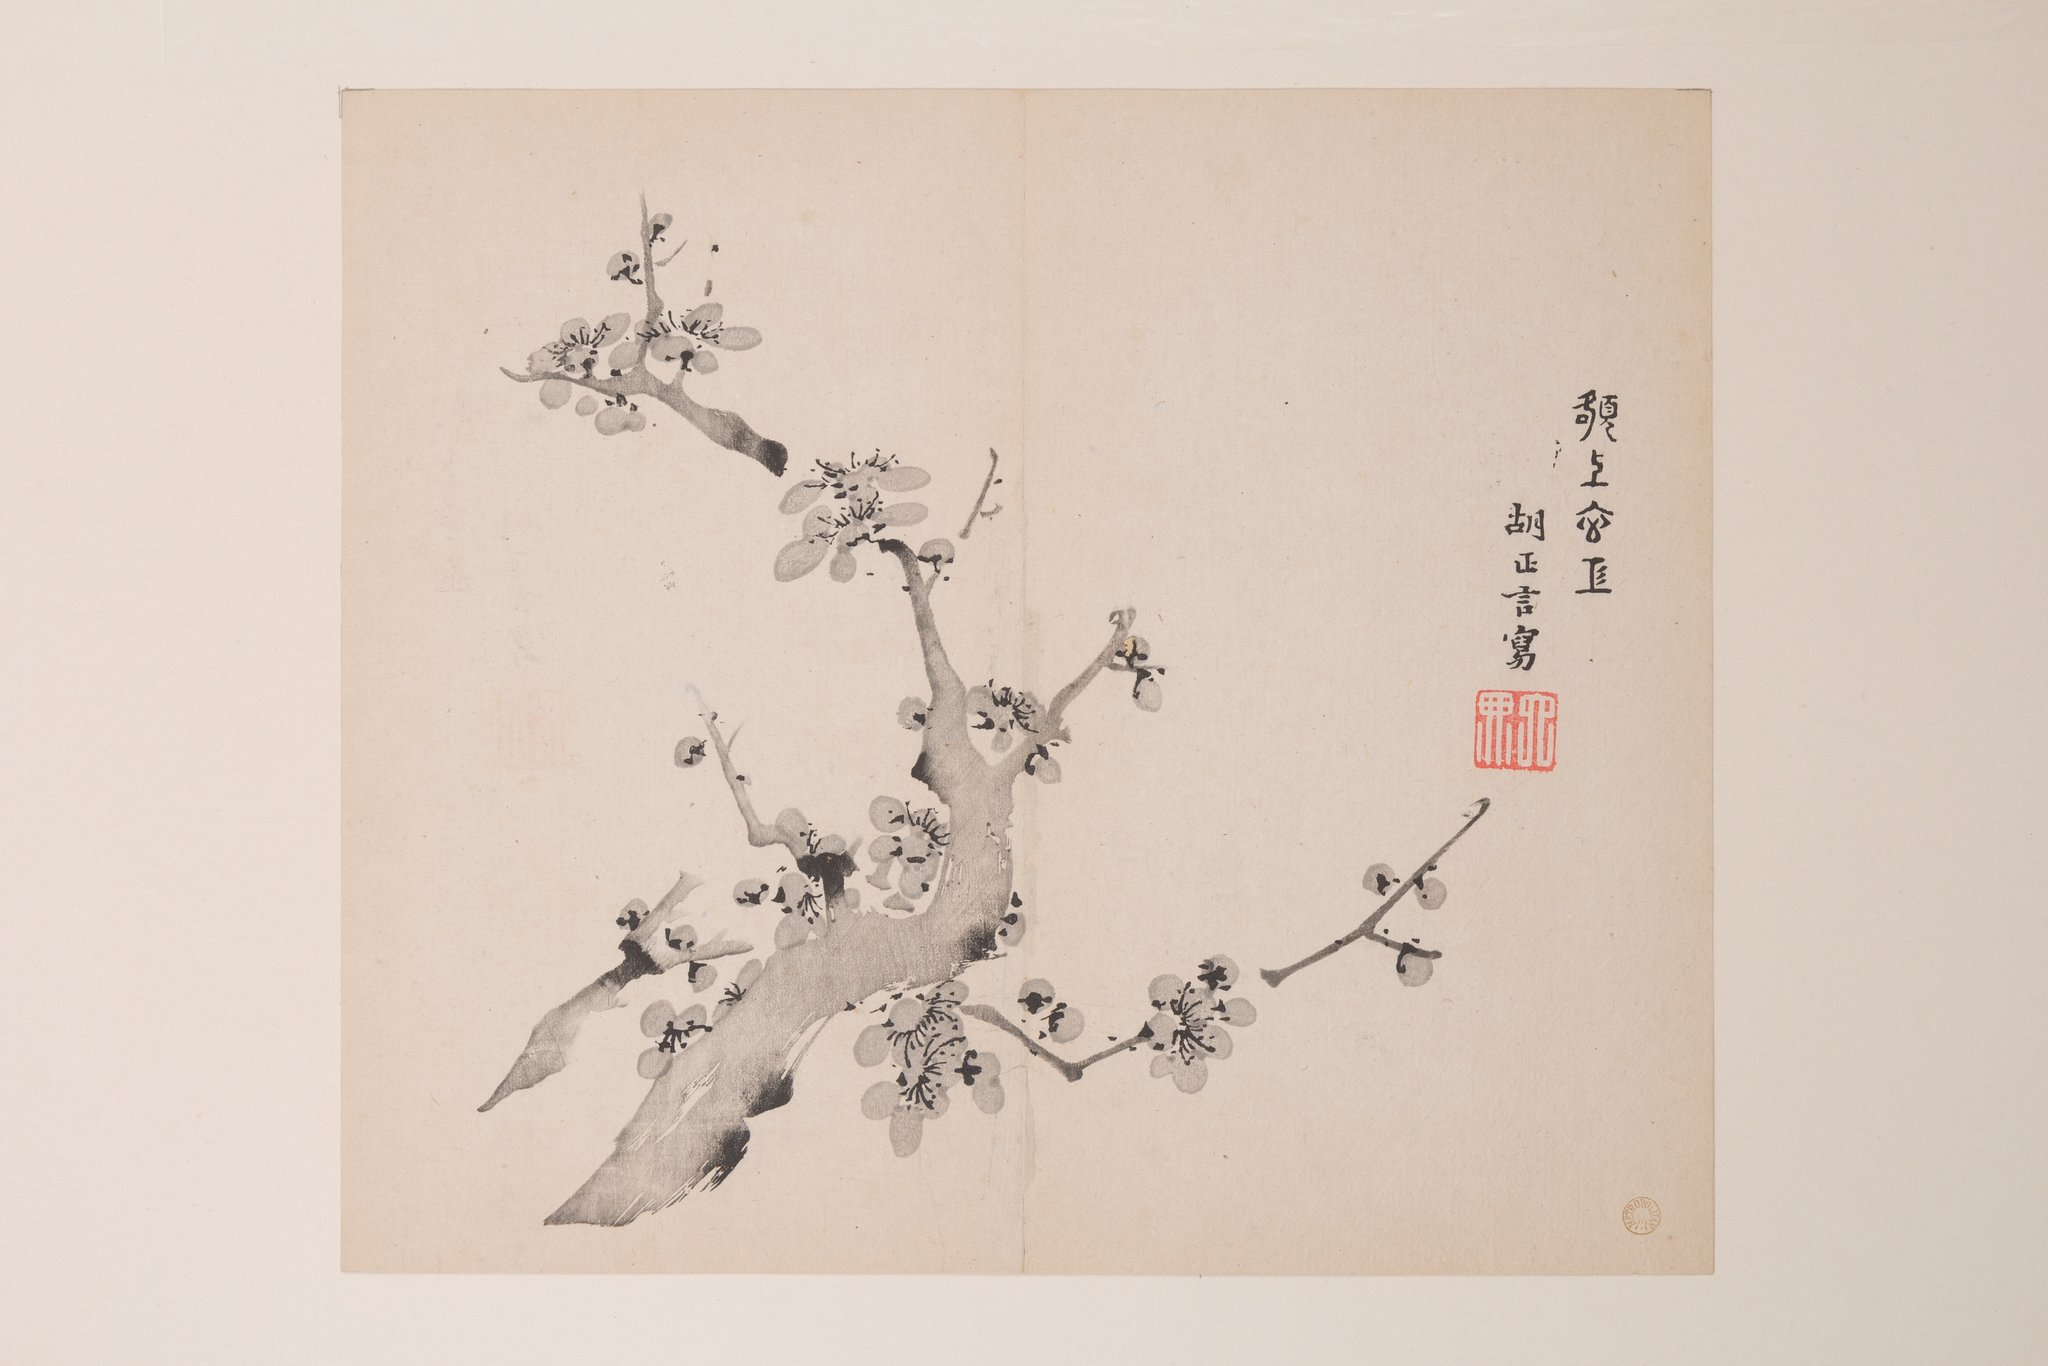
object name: print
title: Page from Shi Zhu Zhai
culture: chinese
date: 1662-1722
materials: ink, paper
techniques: polychrome, woodblock print